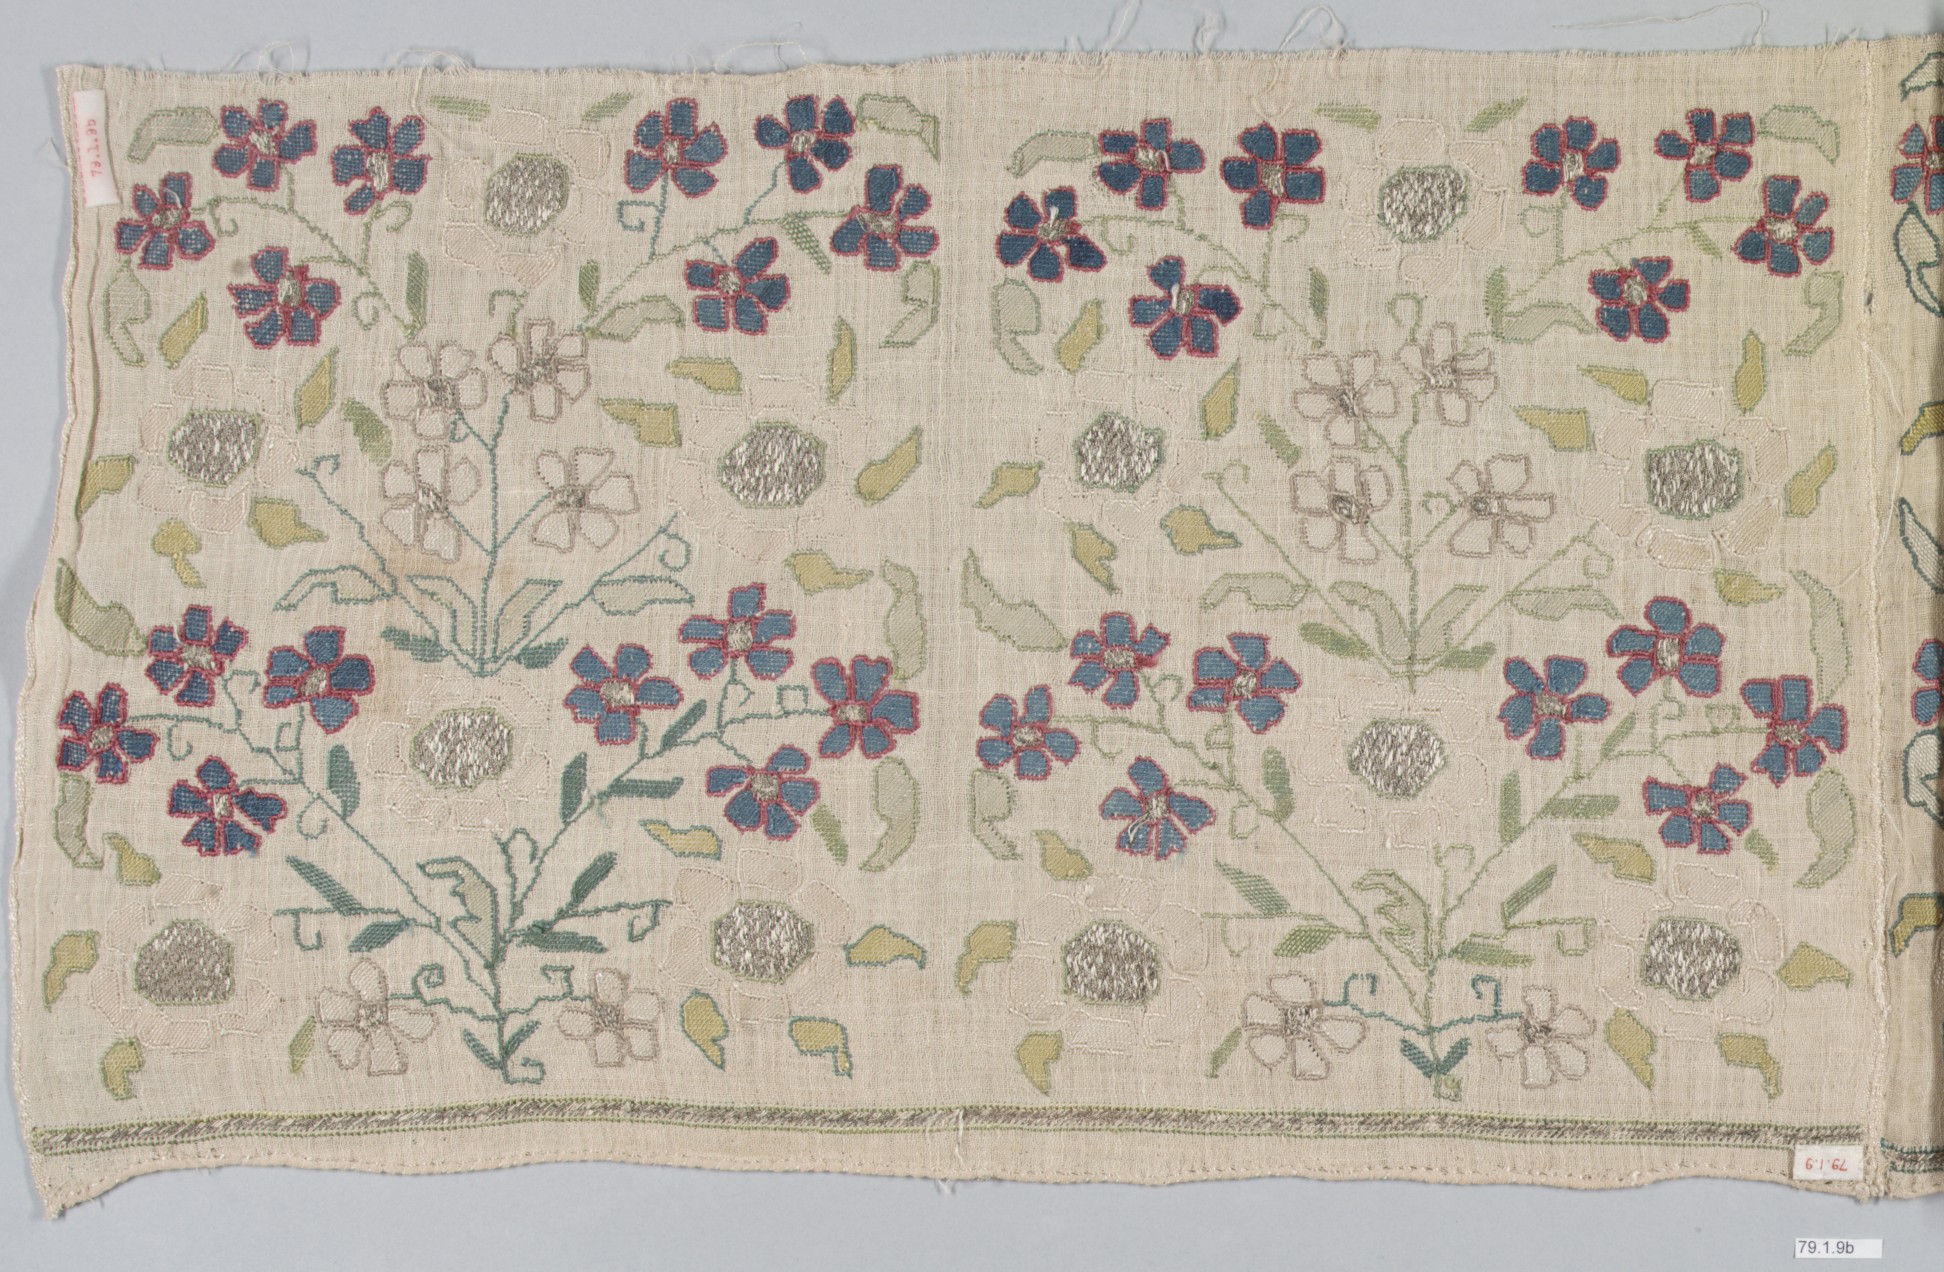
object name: towel end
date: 1801-1833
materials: linen, metal thread, silk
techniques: embroidery, weave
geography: turkey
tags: flowers